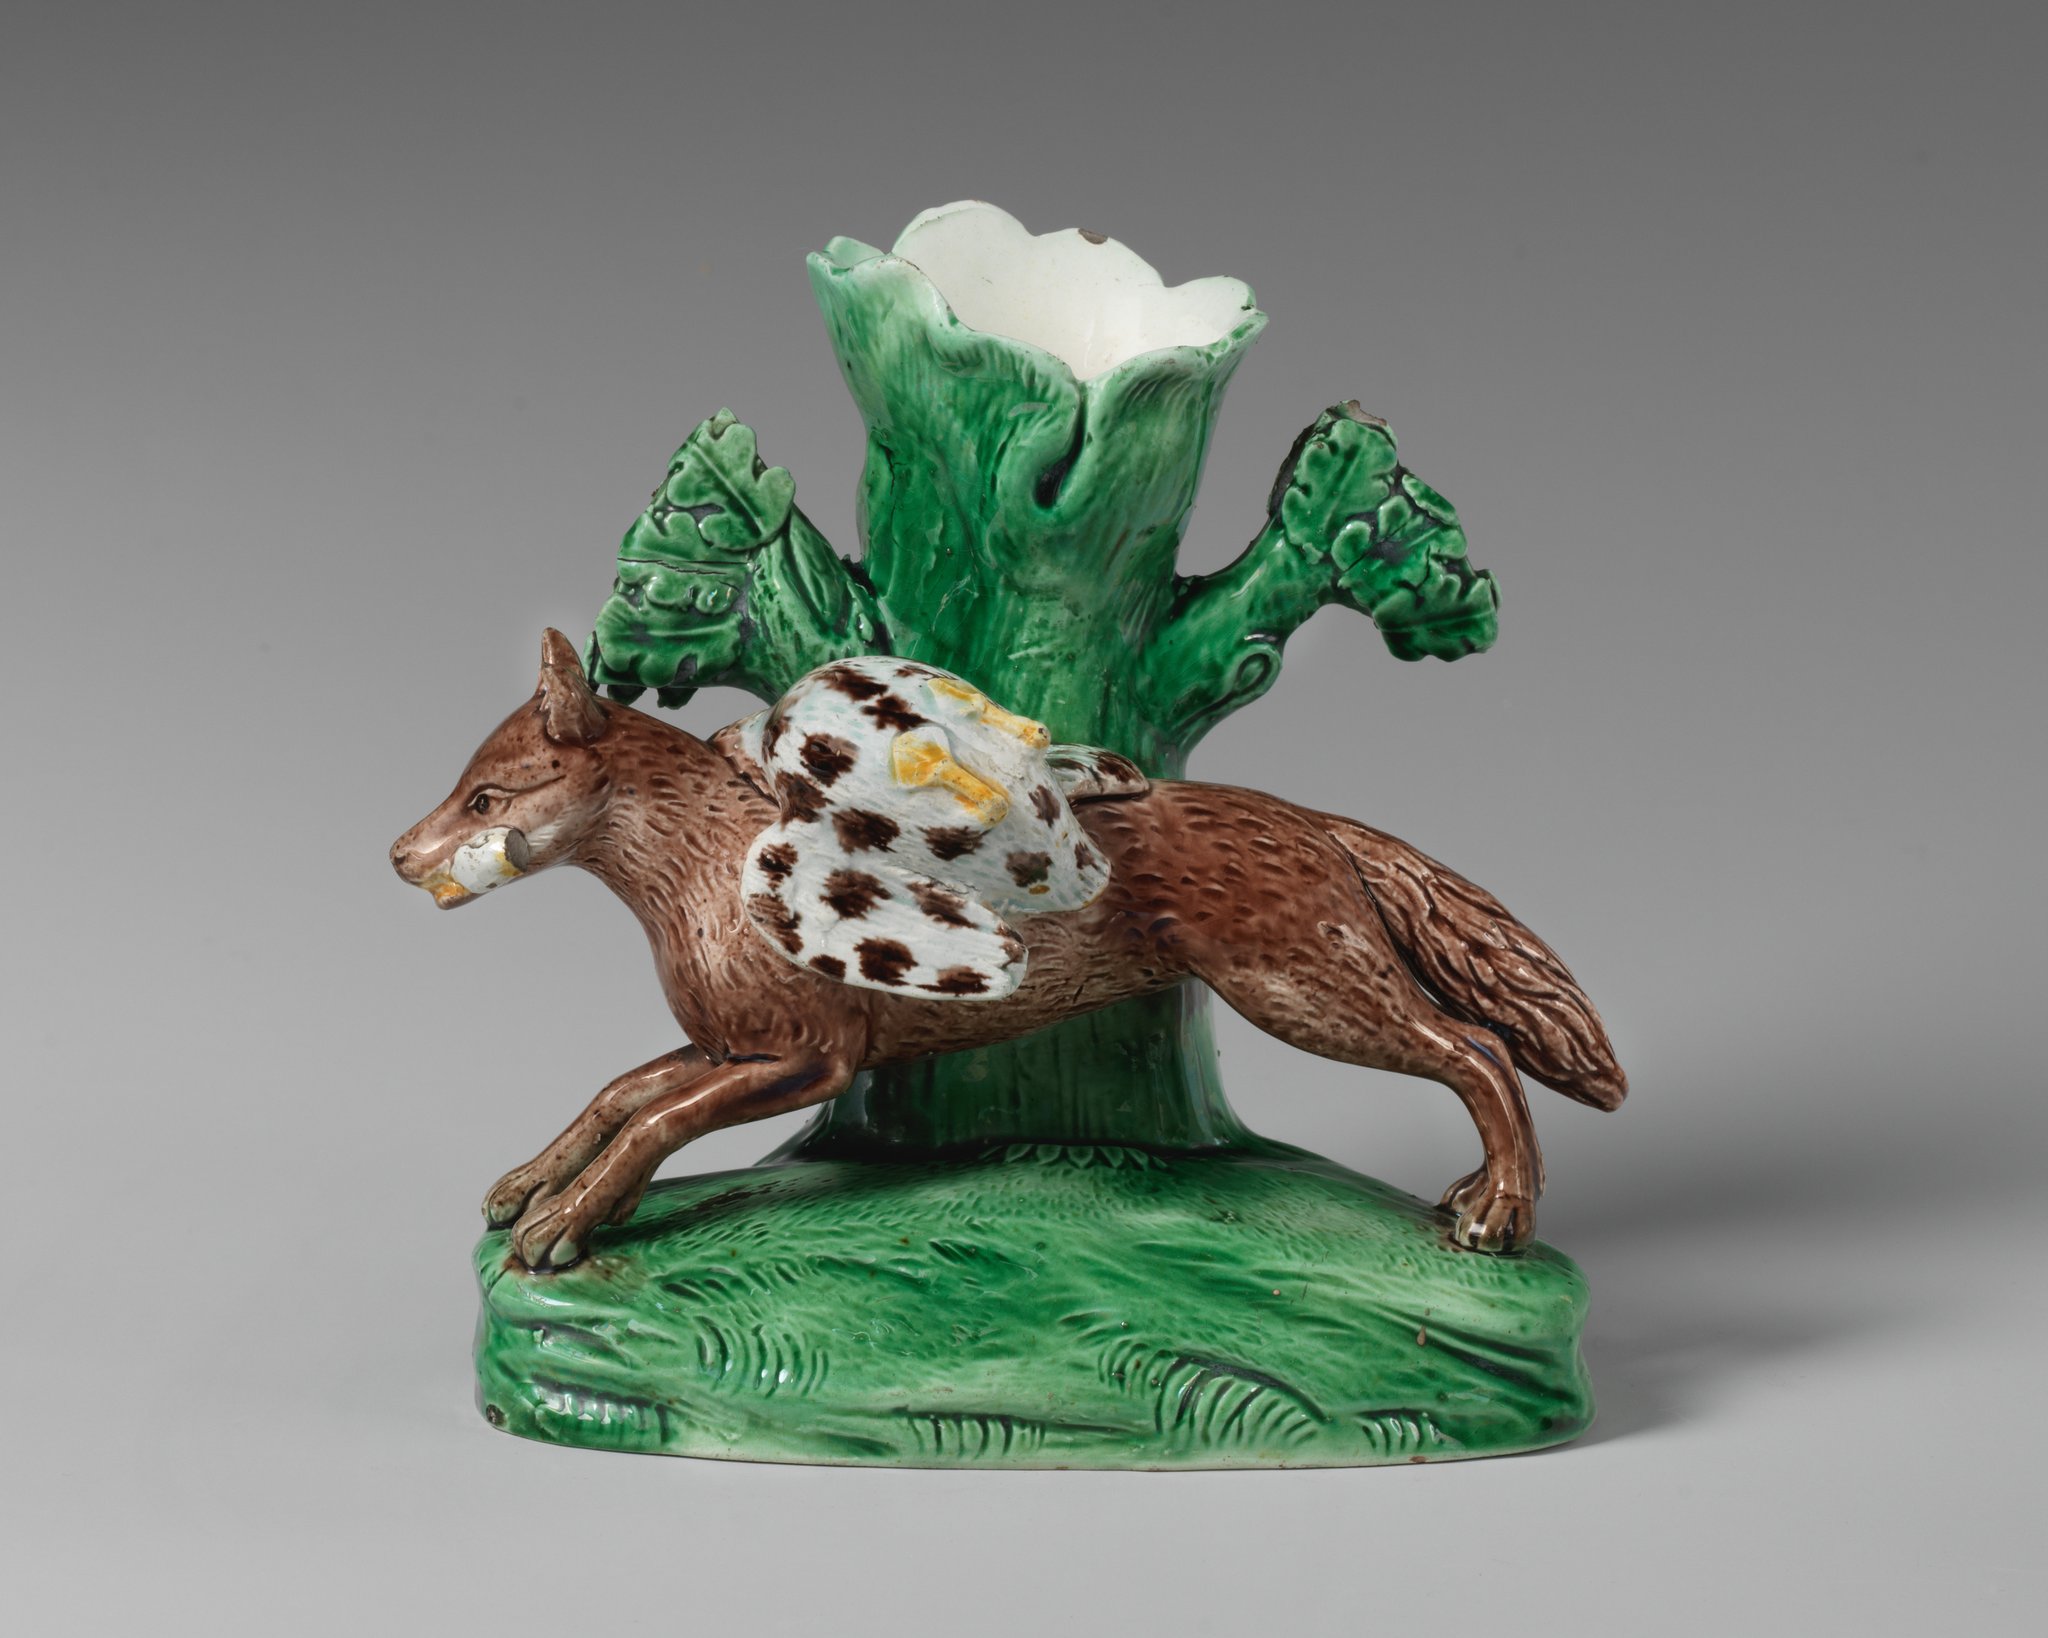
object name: flower holder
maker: ralph wood the younger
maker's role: maker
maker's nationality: british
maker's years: 1748-1795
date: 1780-1790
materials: earthenware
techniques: glazing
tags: foxes